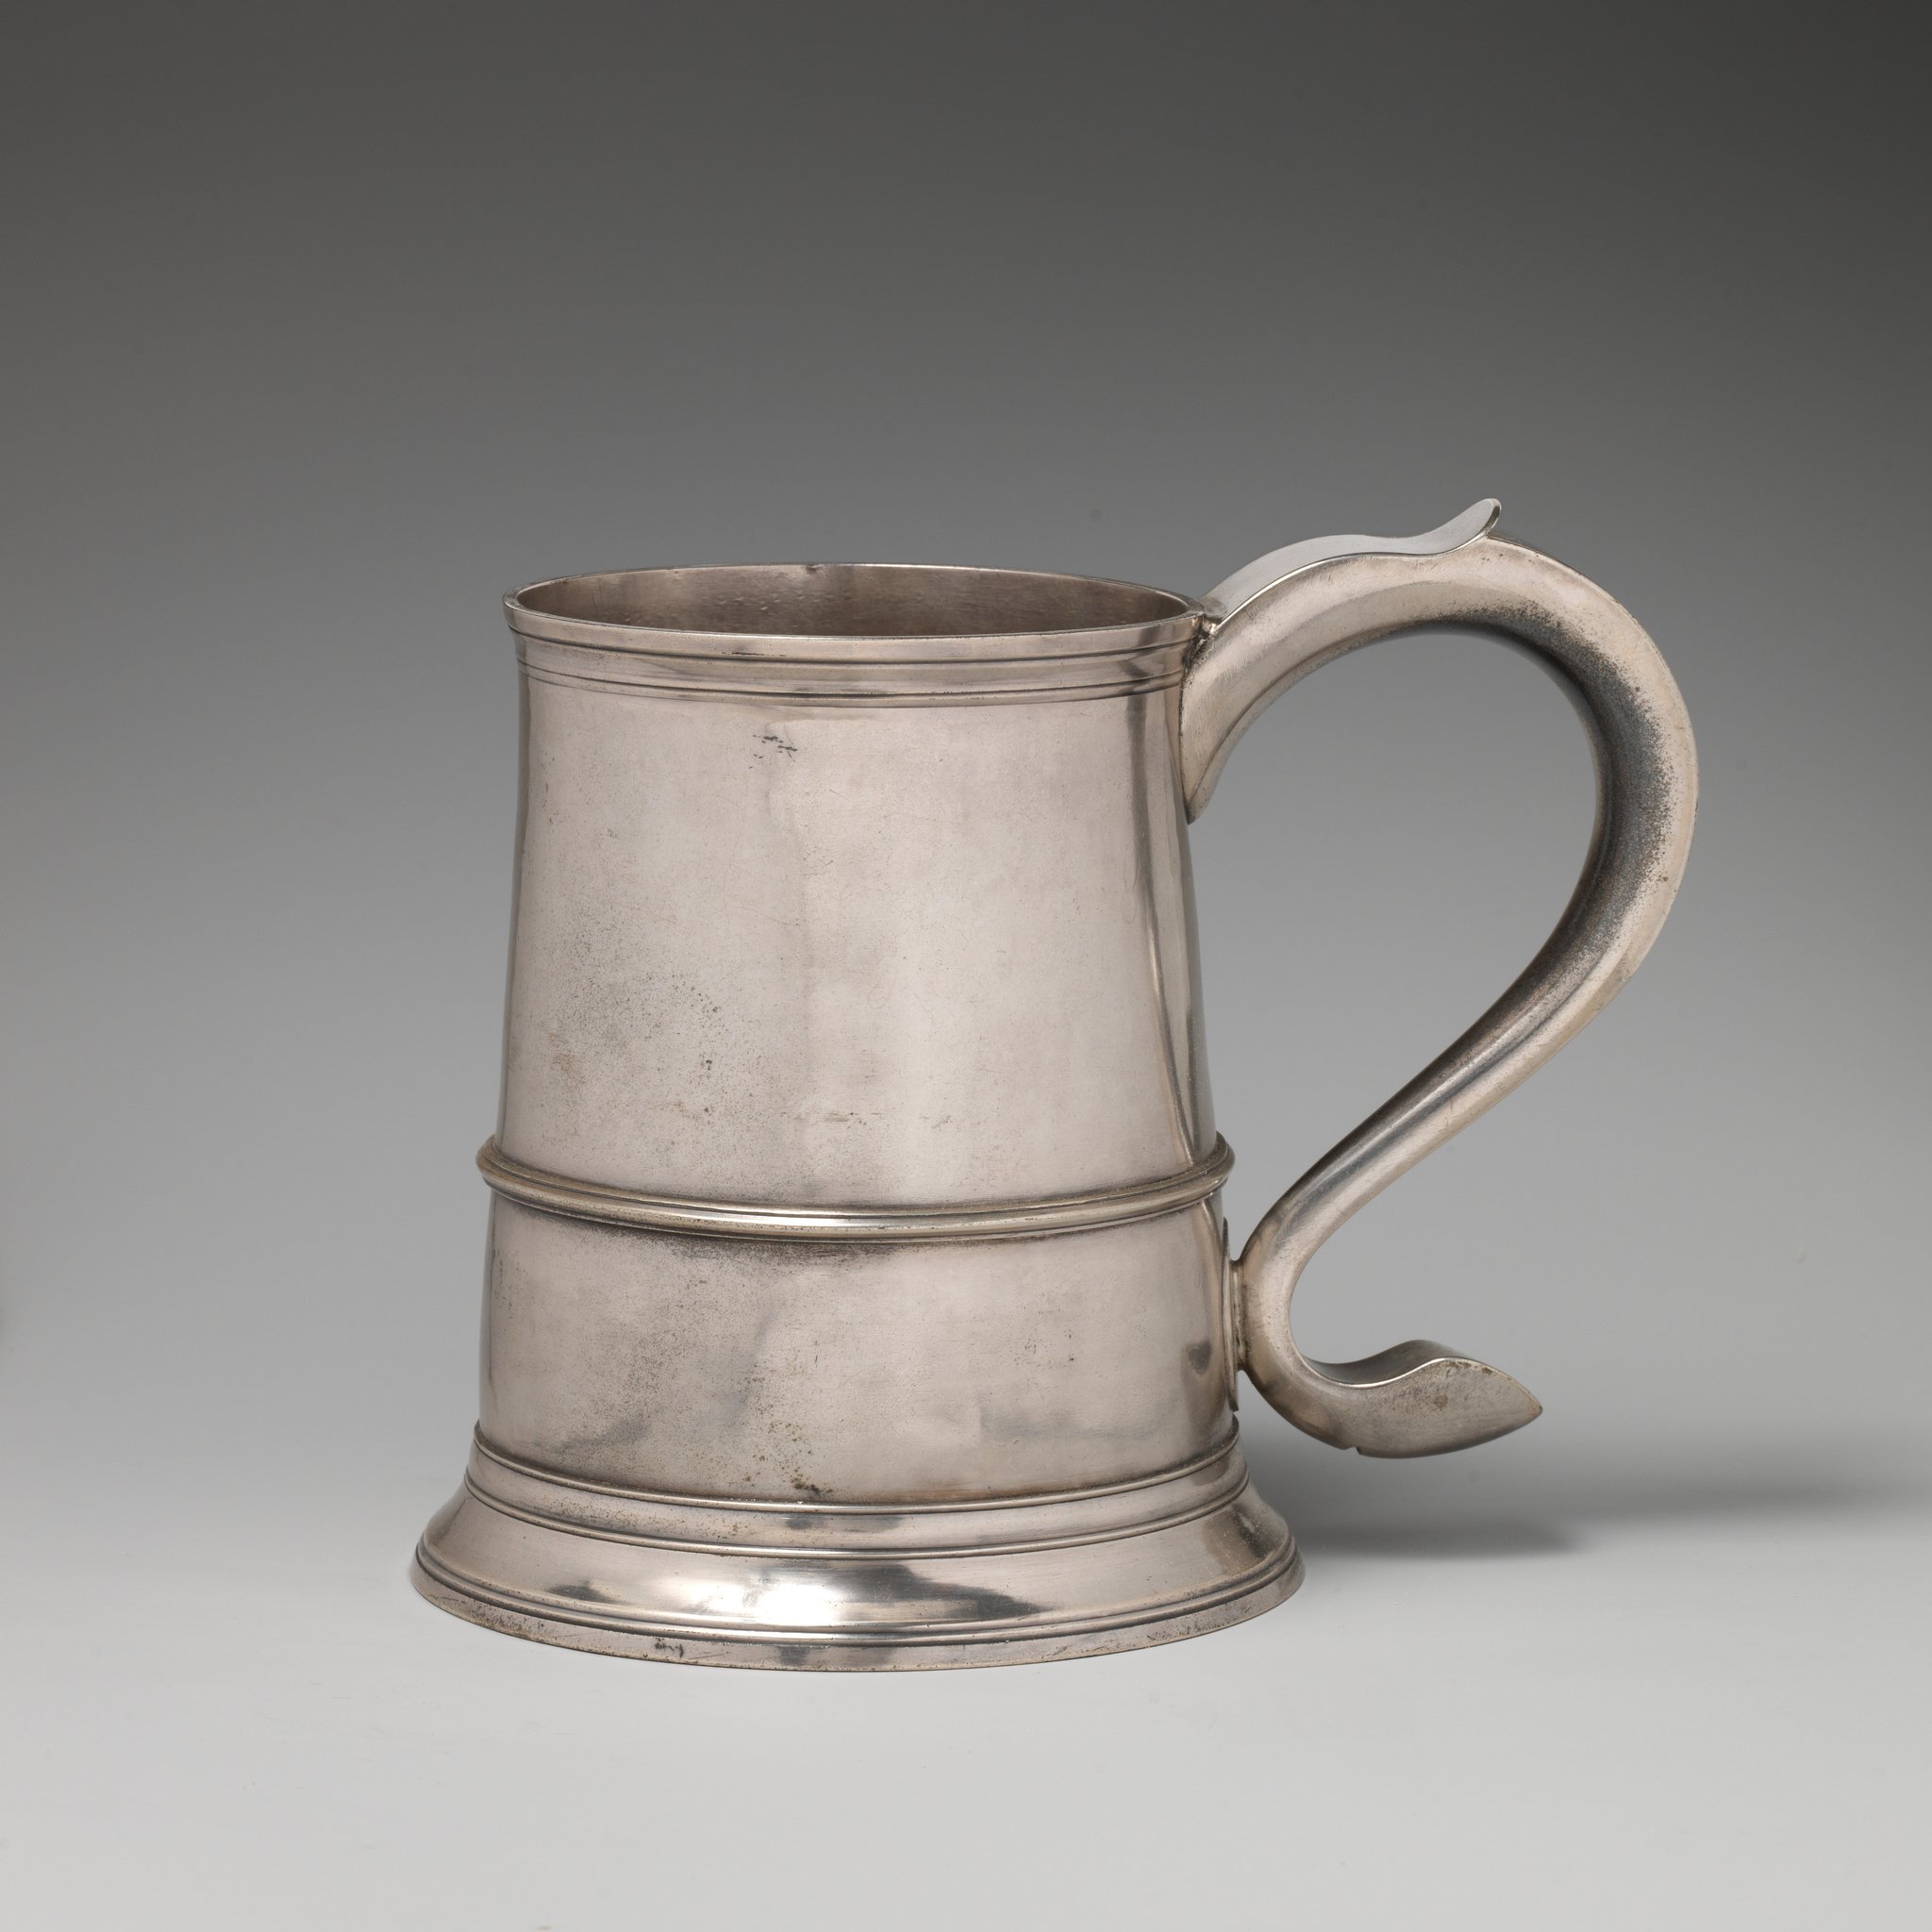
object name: mug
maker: john langlands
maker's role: maker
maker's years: 1725-1825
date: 1759-1760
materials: silver